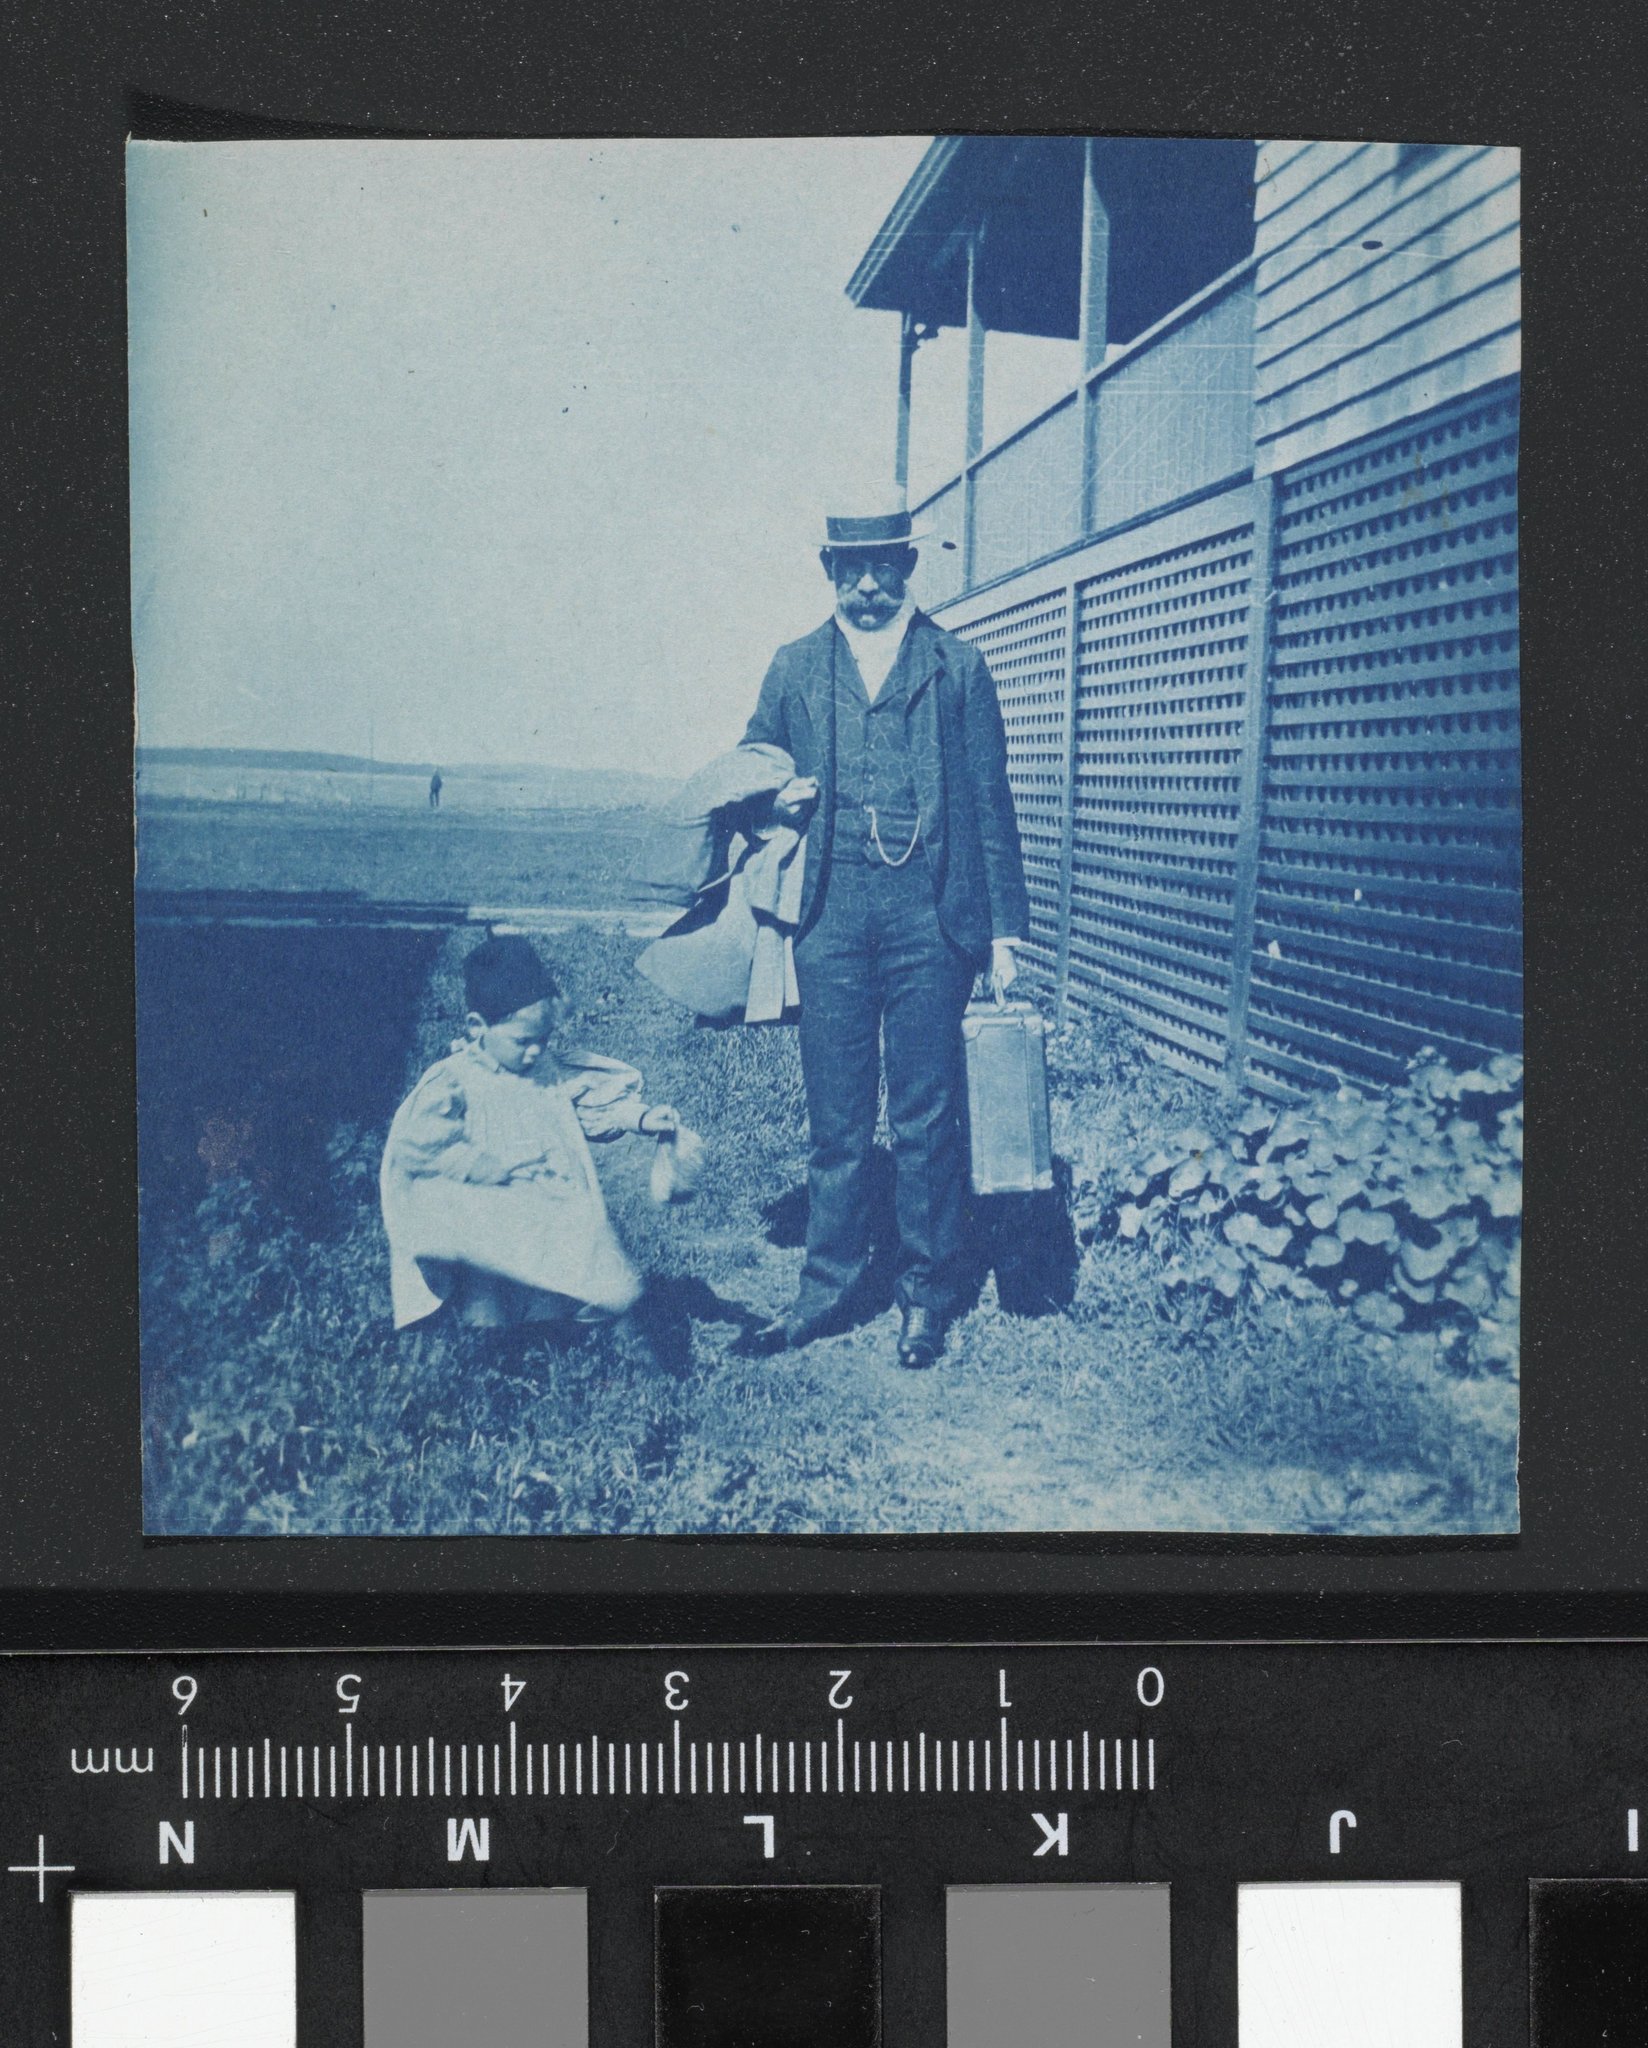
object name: photograph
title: Kind en een man met een koffer in de hand, Verenigde Staten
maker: Anonymous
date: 1900-1920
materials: paper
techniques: cyanotype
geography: united states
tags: adult man, child, historical persons, united states of america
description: Onderdeel van Fotoalbum met 53 cyanotypieën van kinderen, paarden, huizen, boten en strandtaferelen in de Verenigde Staten.